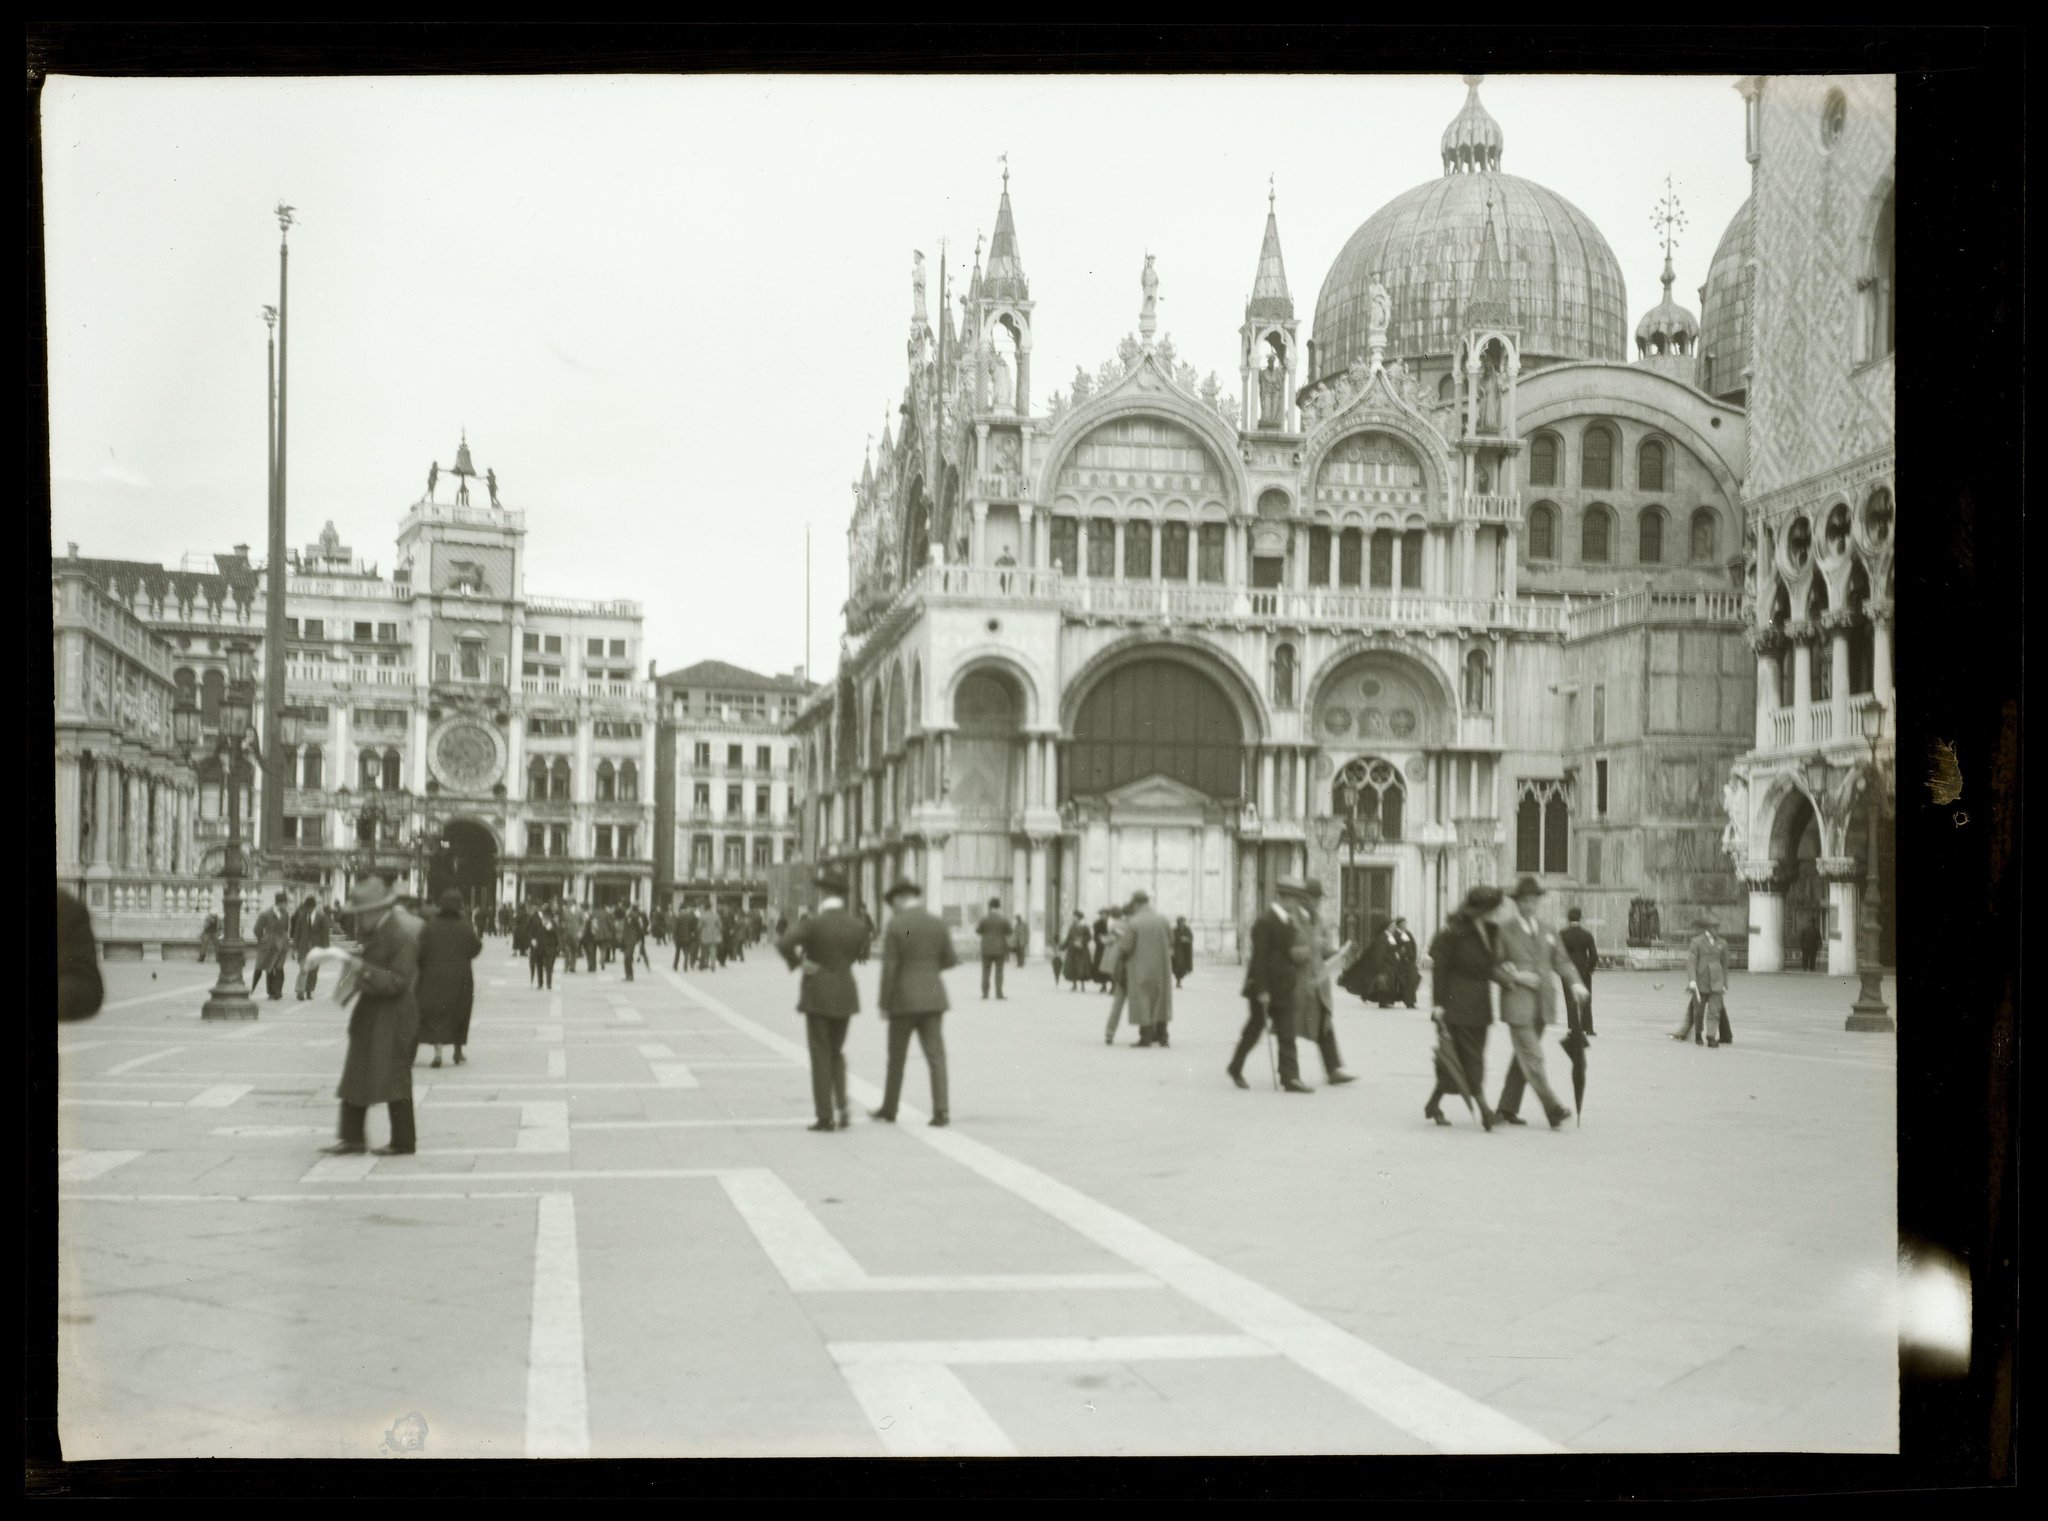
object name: negative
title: Filmnegatief met opname van Venetië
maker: Anonymous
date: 1907-1935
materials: film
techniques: gelatin silver negative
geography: venice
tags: venice